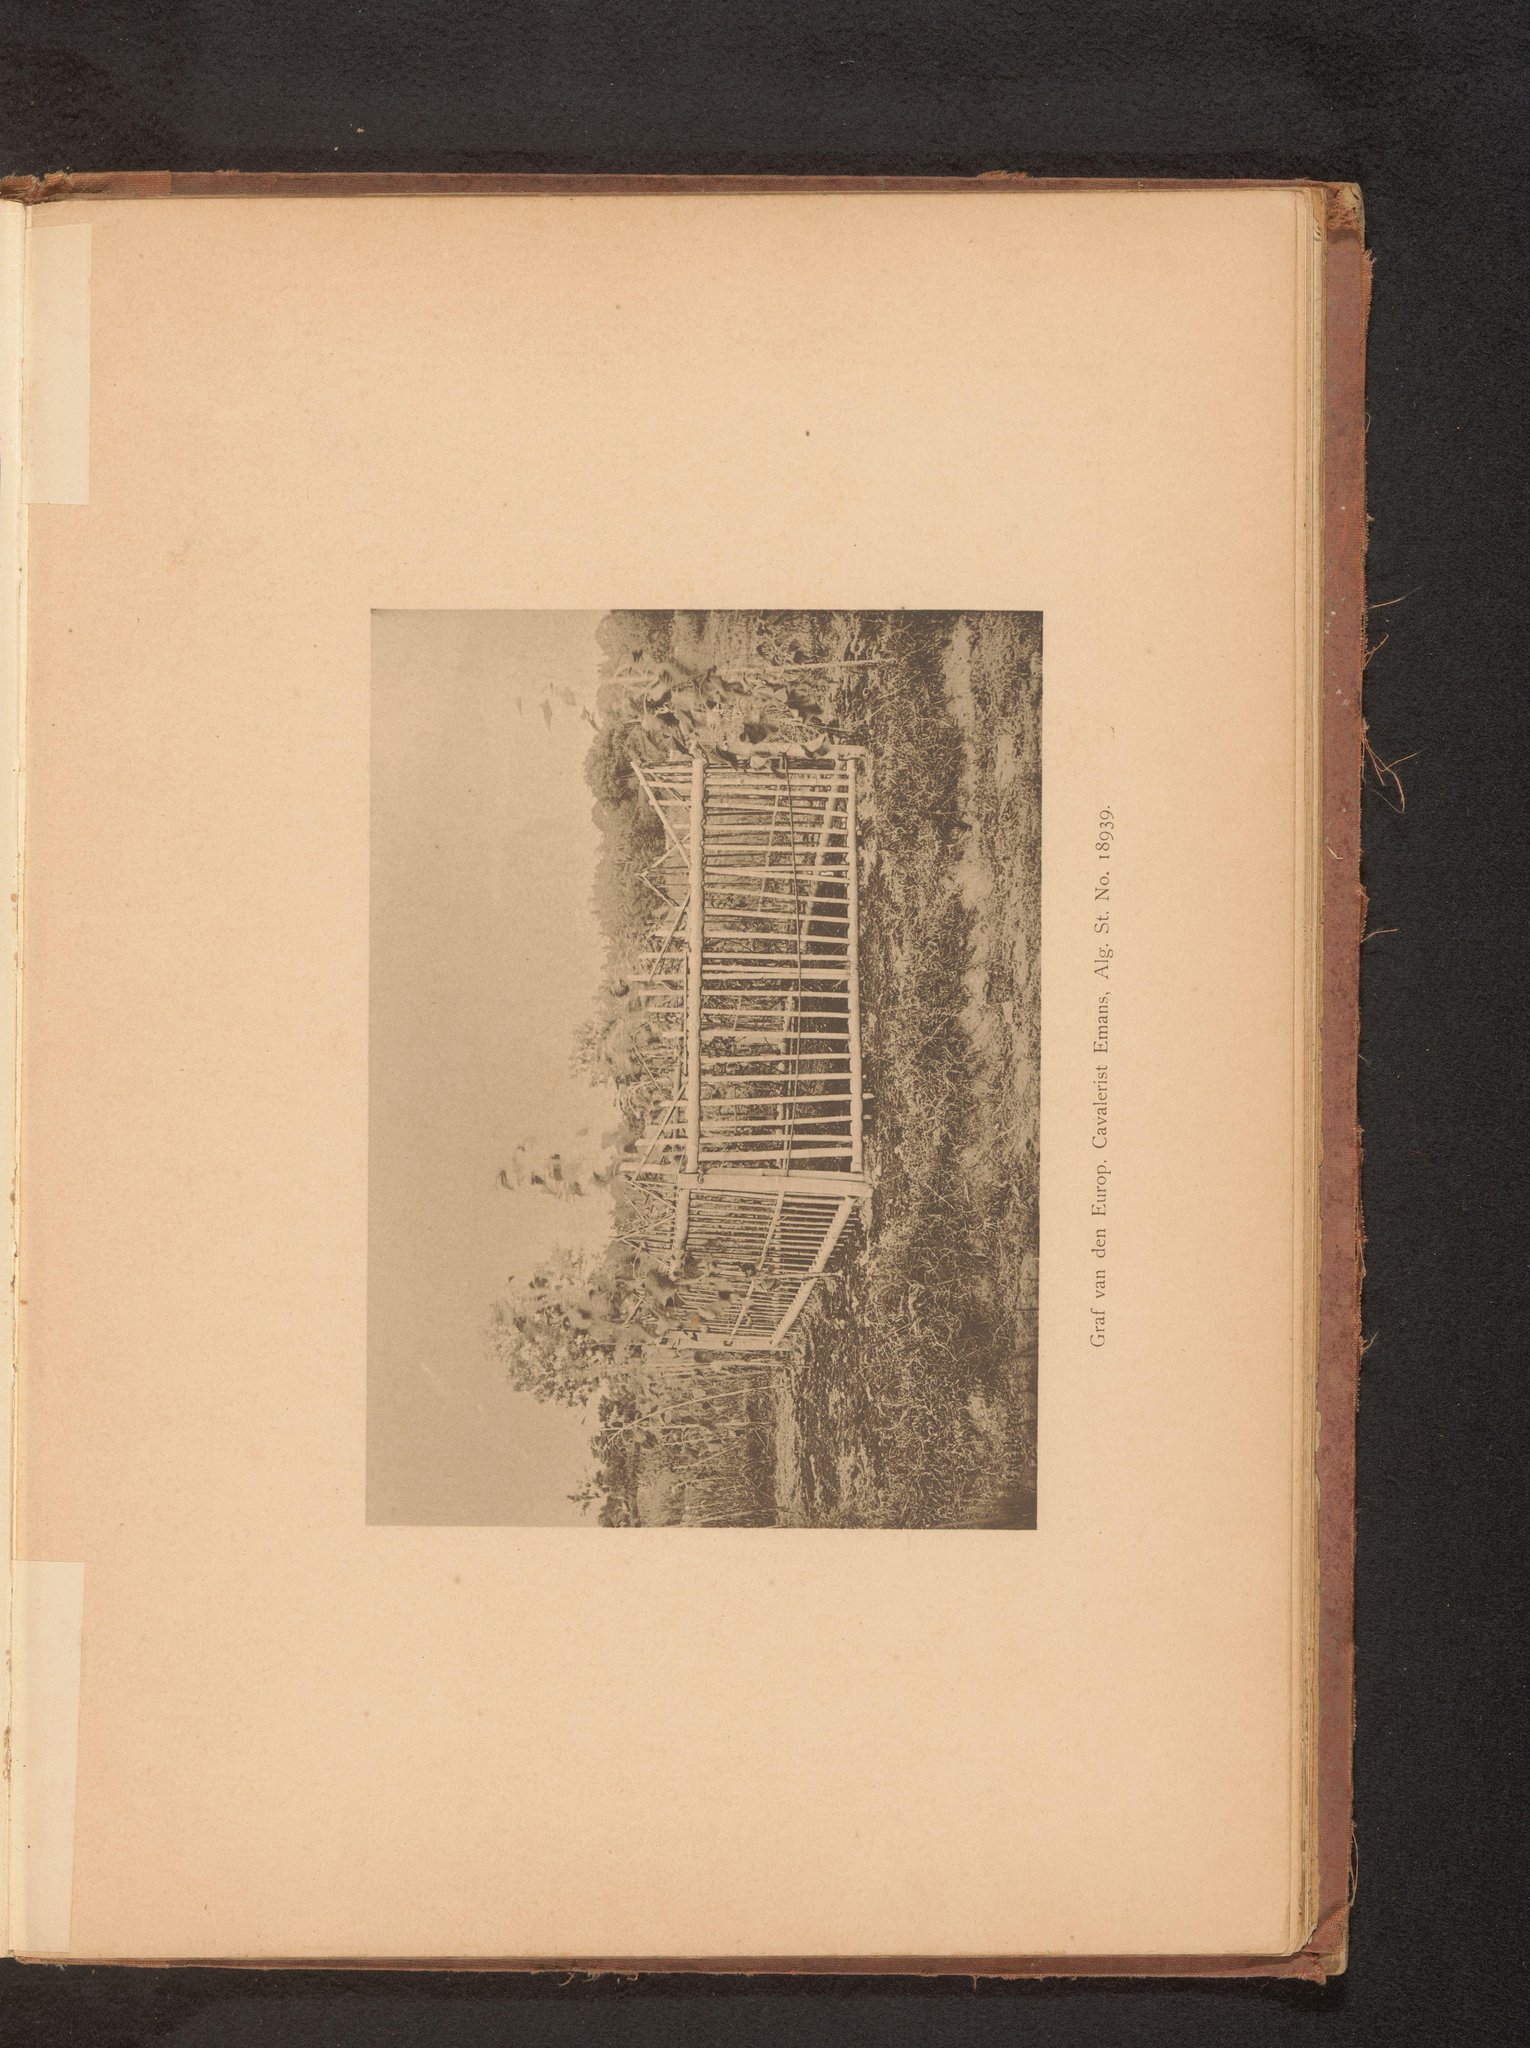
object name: photomechanical print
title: Graf van Europ. Cavalerist Emans, Alg. St. No. 18939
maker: christiaan johan neeb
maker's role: arts, fotograaf, officier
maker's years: 1860-1925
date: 1892-1897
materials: paper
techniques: photograph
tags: landscape with ruins, indonesia